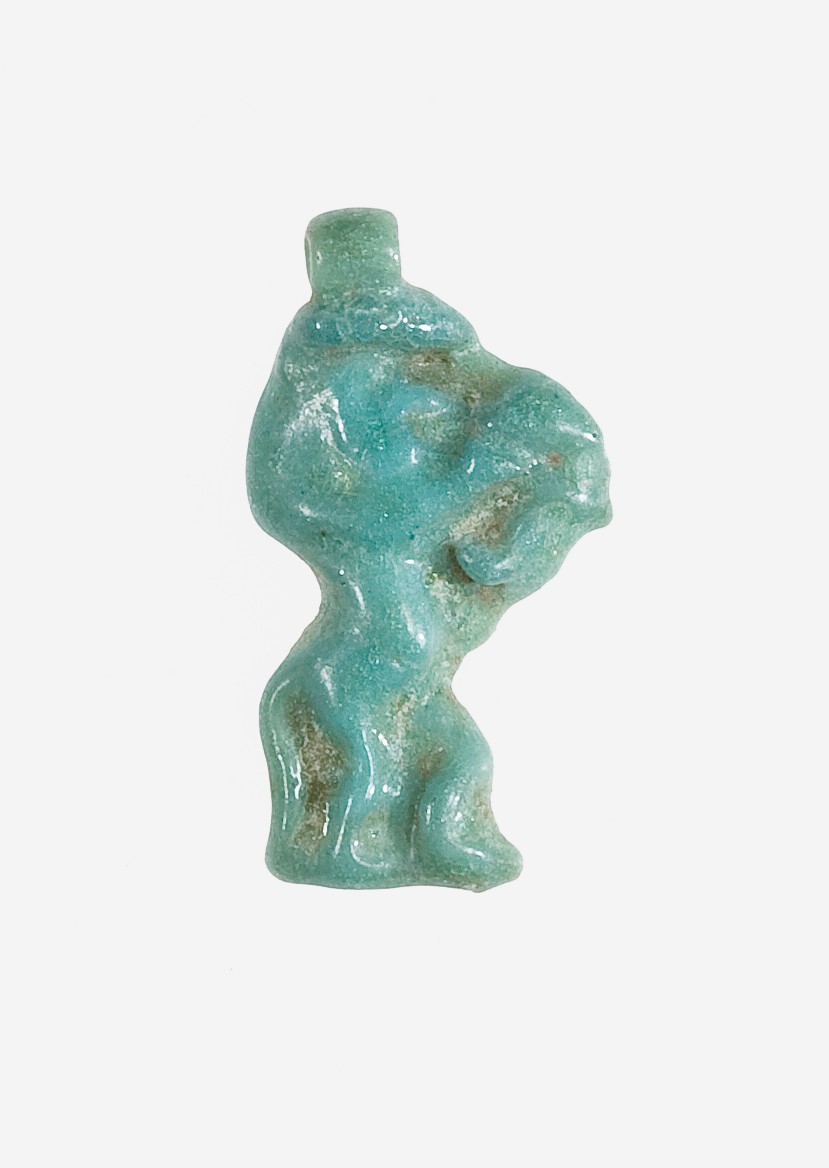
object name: pendant, be, tambourine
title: Amulet of Bes with tambourine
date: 1390-1352 BCE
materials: faience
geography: egypt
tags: musical instruments,bes